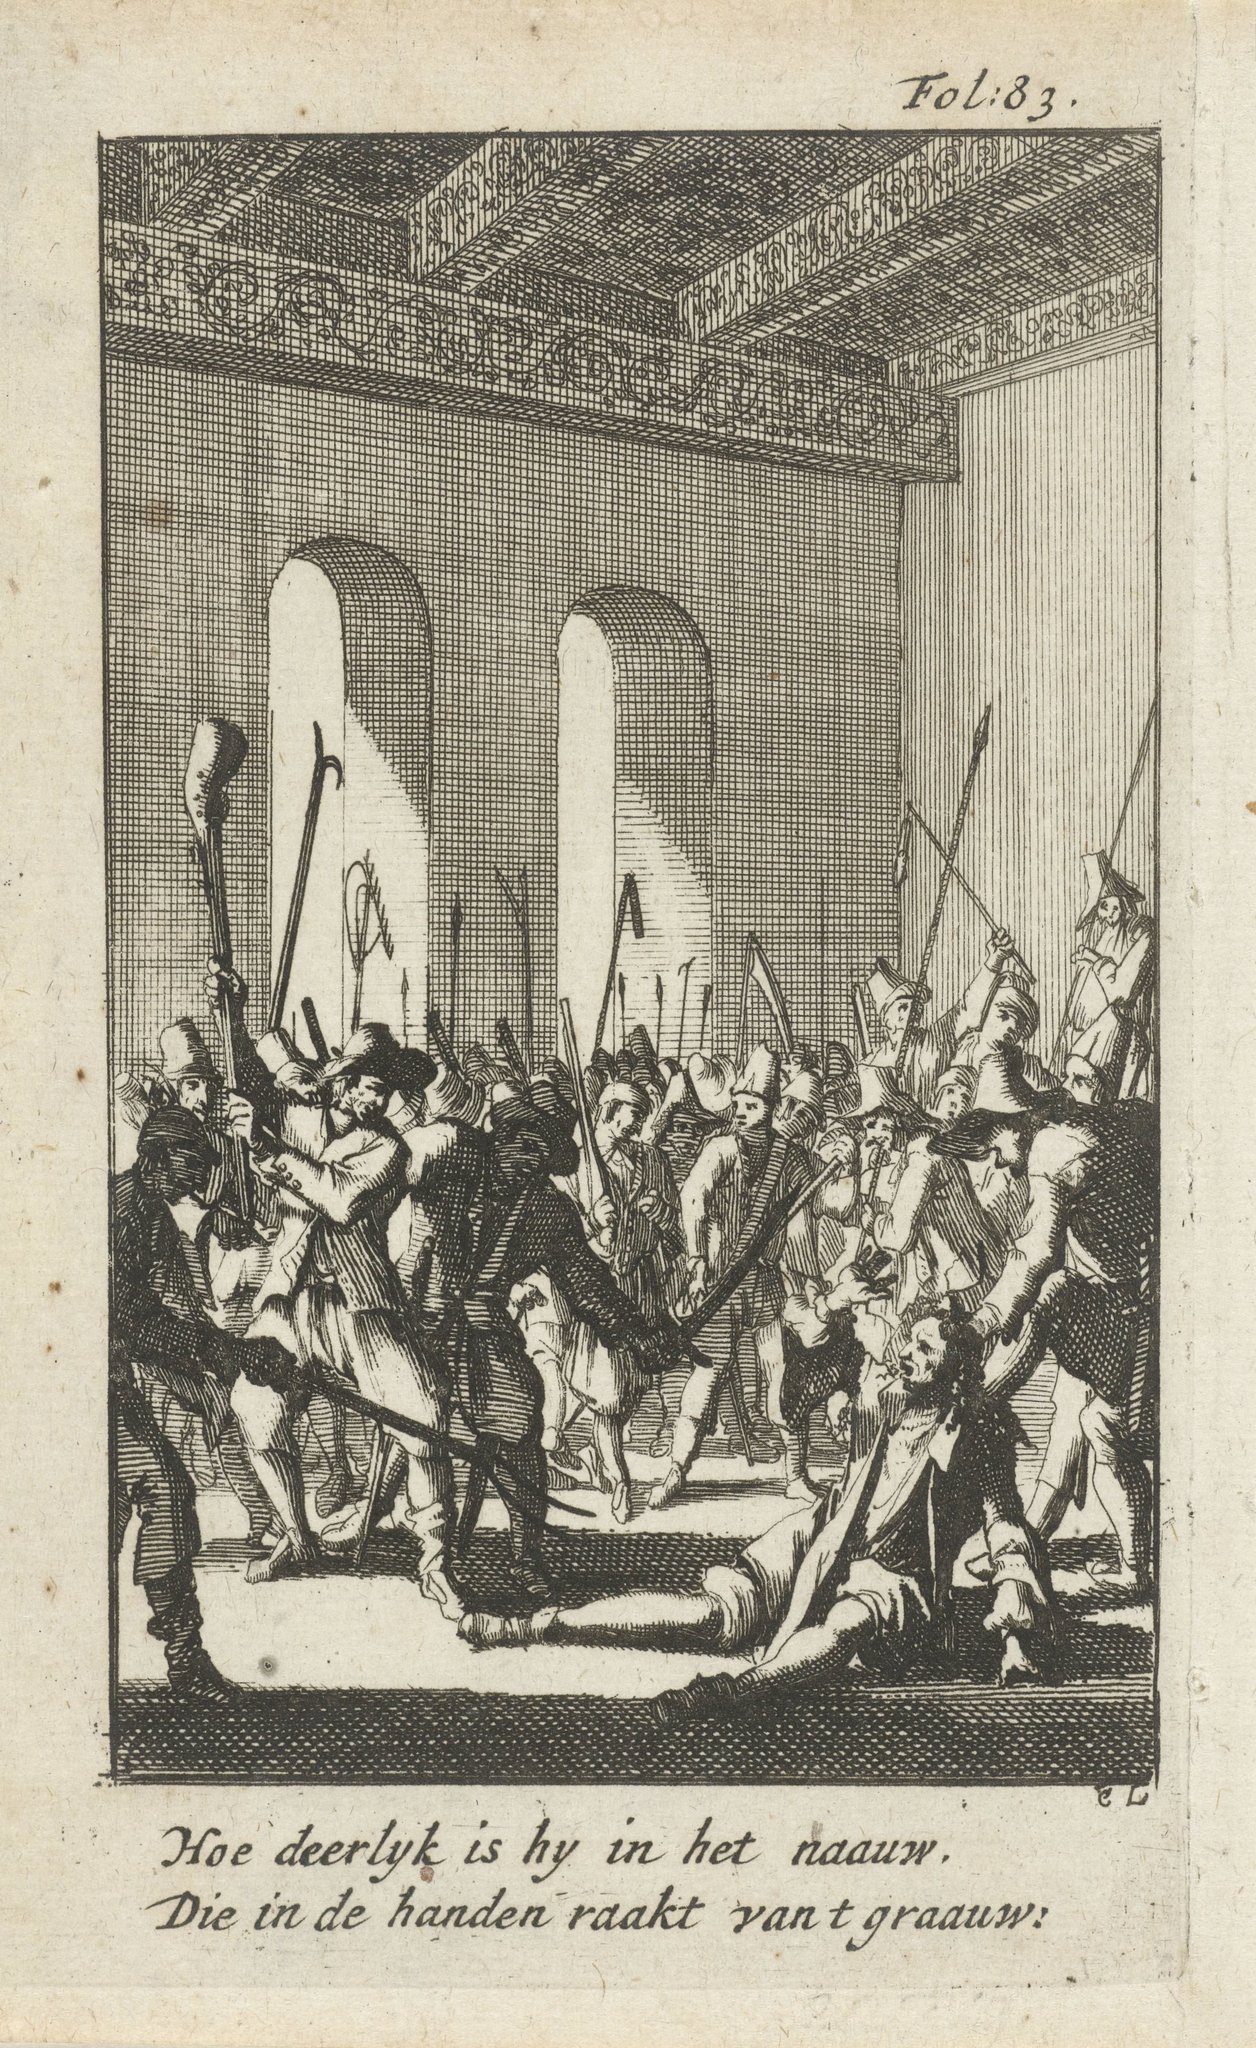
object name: book illustration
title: Burgemeester Filips van den Brande mishandeld door de opstandige boeren in het stadhuis, 1672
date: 1692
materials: paper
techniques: etching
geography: amsterdam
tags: mayor, street-fights, riots, middelburg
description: Illustratie uit: Beronicius, Petrus Johannes. Boeren- en overheidsstrĳd. Amsterdam: Jan Claesz ten Hoorn, 1692.